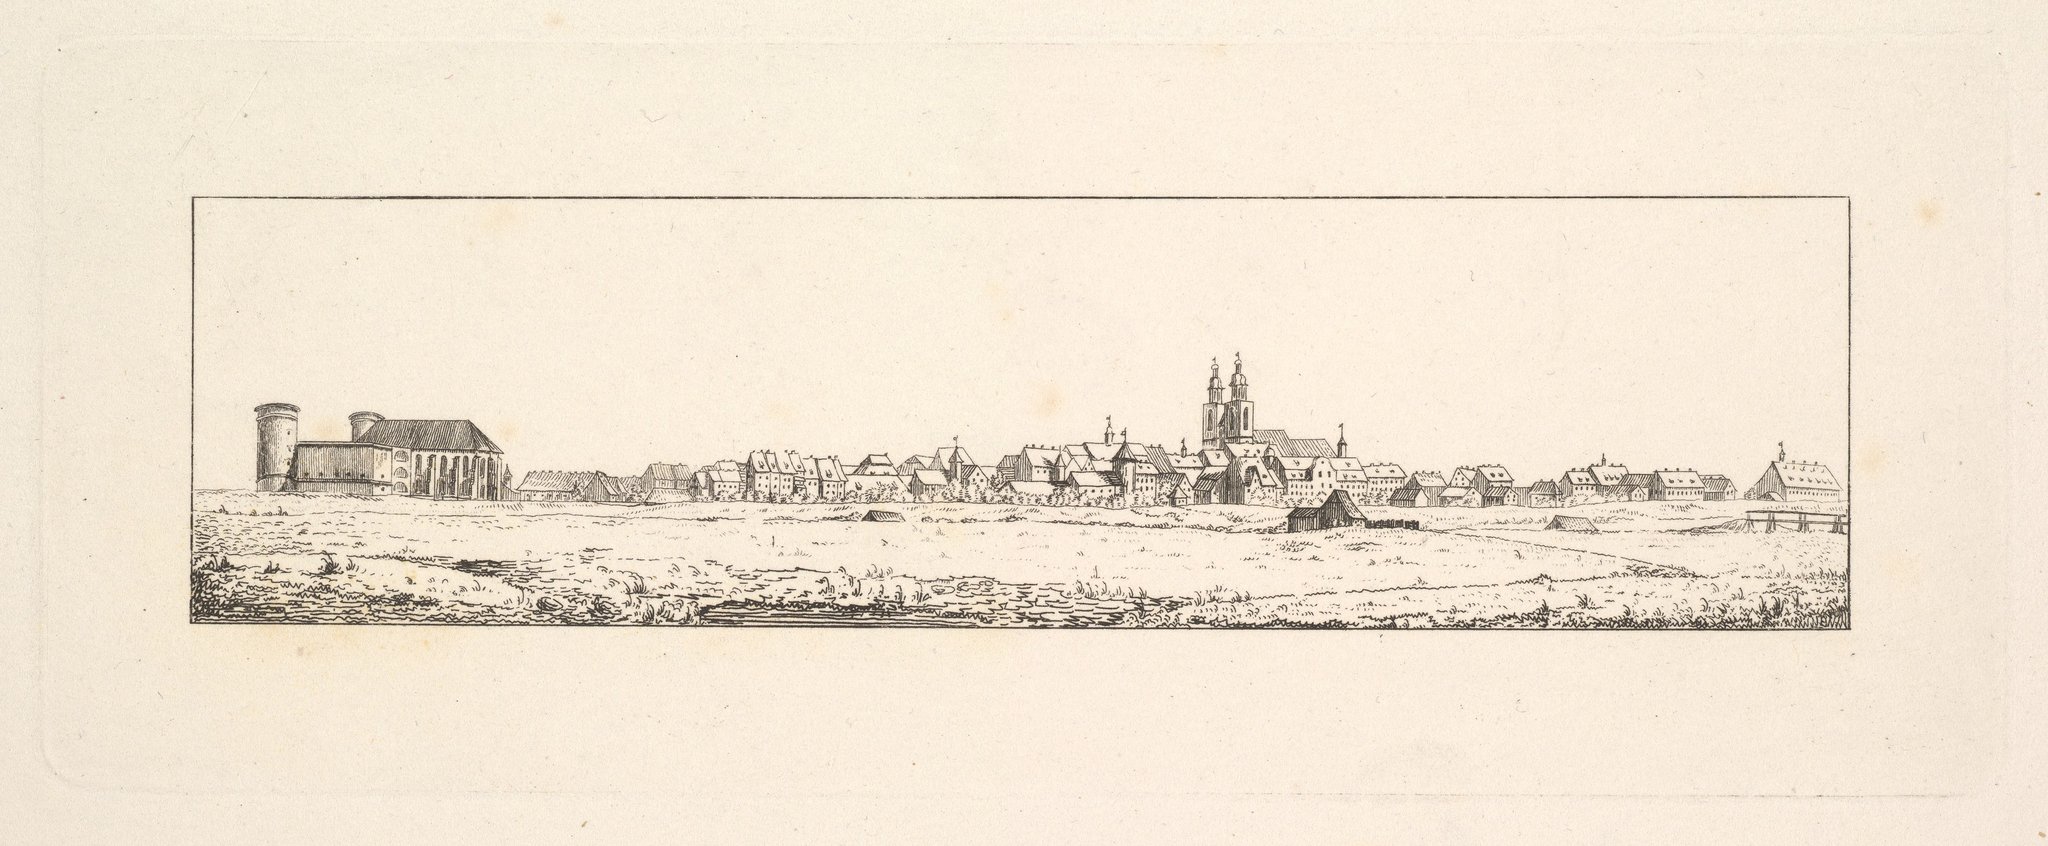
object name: print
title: View of an Old Town with a Church and High Gabled Houses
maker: johann gottfried schadow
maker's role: artist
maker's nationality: german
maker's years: 1764-1850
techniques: etching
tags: houses,churches,towns